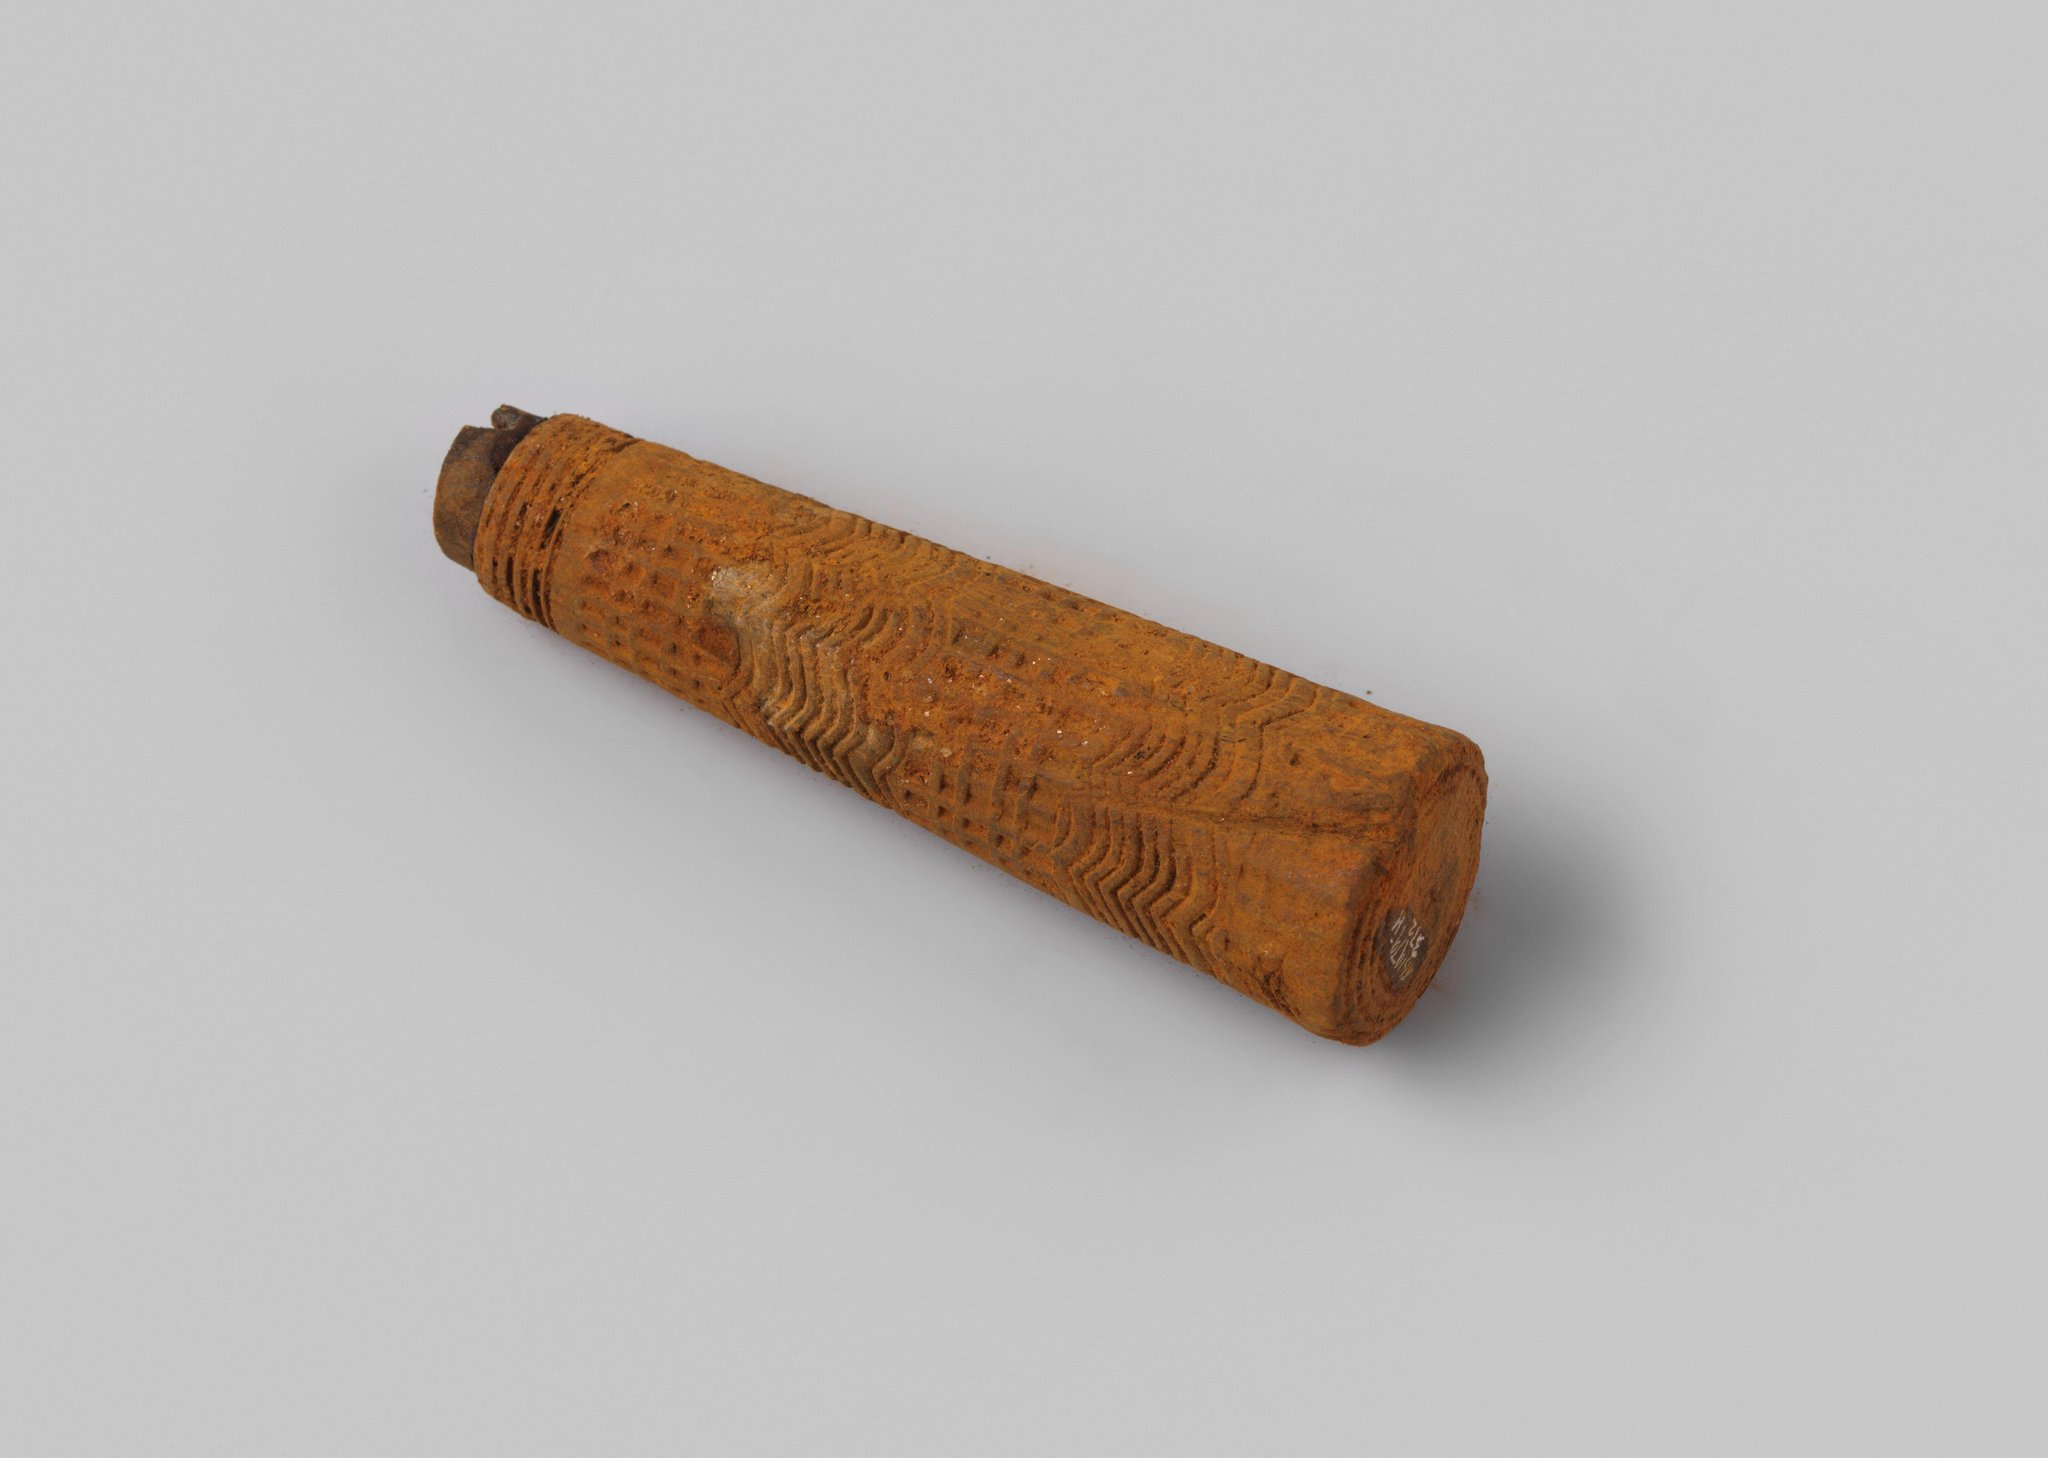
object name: knife handle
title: Messenheft uit het wrak van de Oost-Indiëvaarder Hollandia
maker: Anonymous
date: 1700-1743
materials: wood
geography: netherlands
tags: verenigde oostindische compagnie, hollandia (schip), annet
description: Knife, handle, cylindrical: tapering; id. NG 1979-403H, ferrules id. NG 1980-27H426.